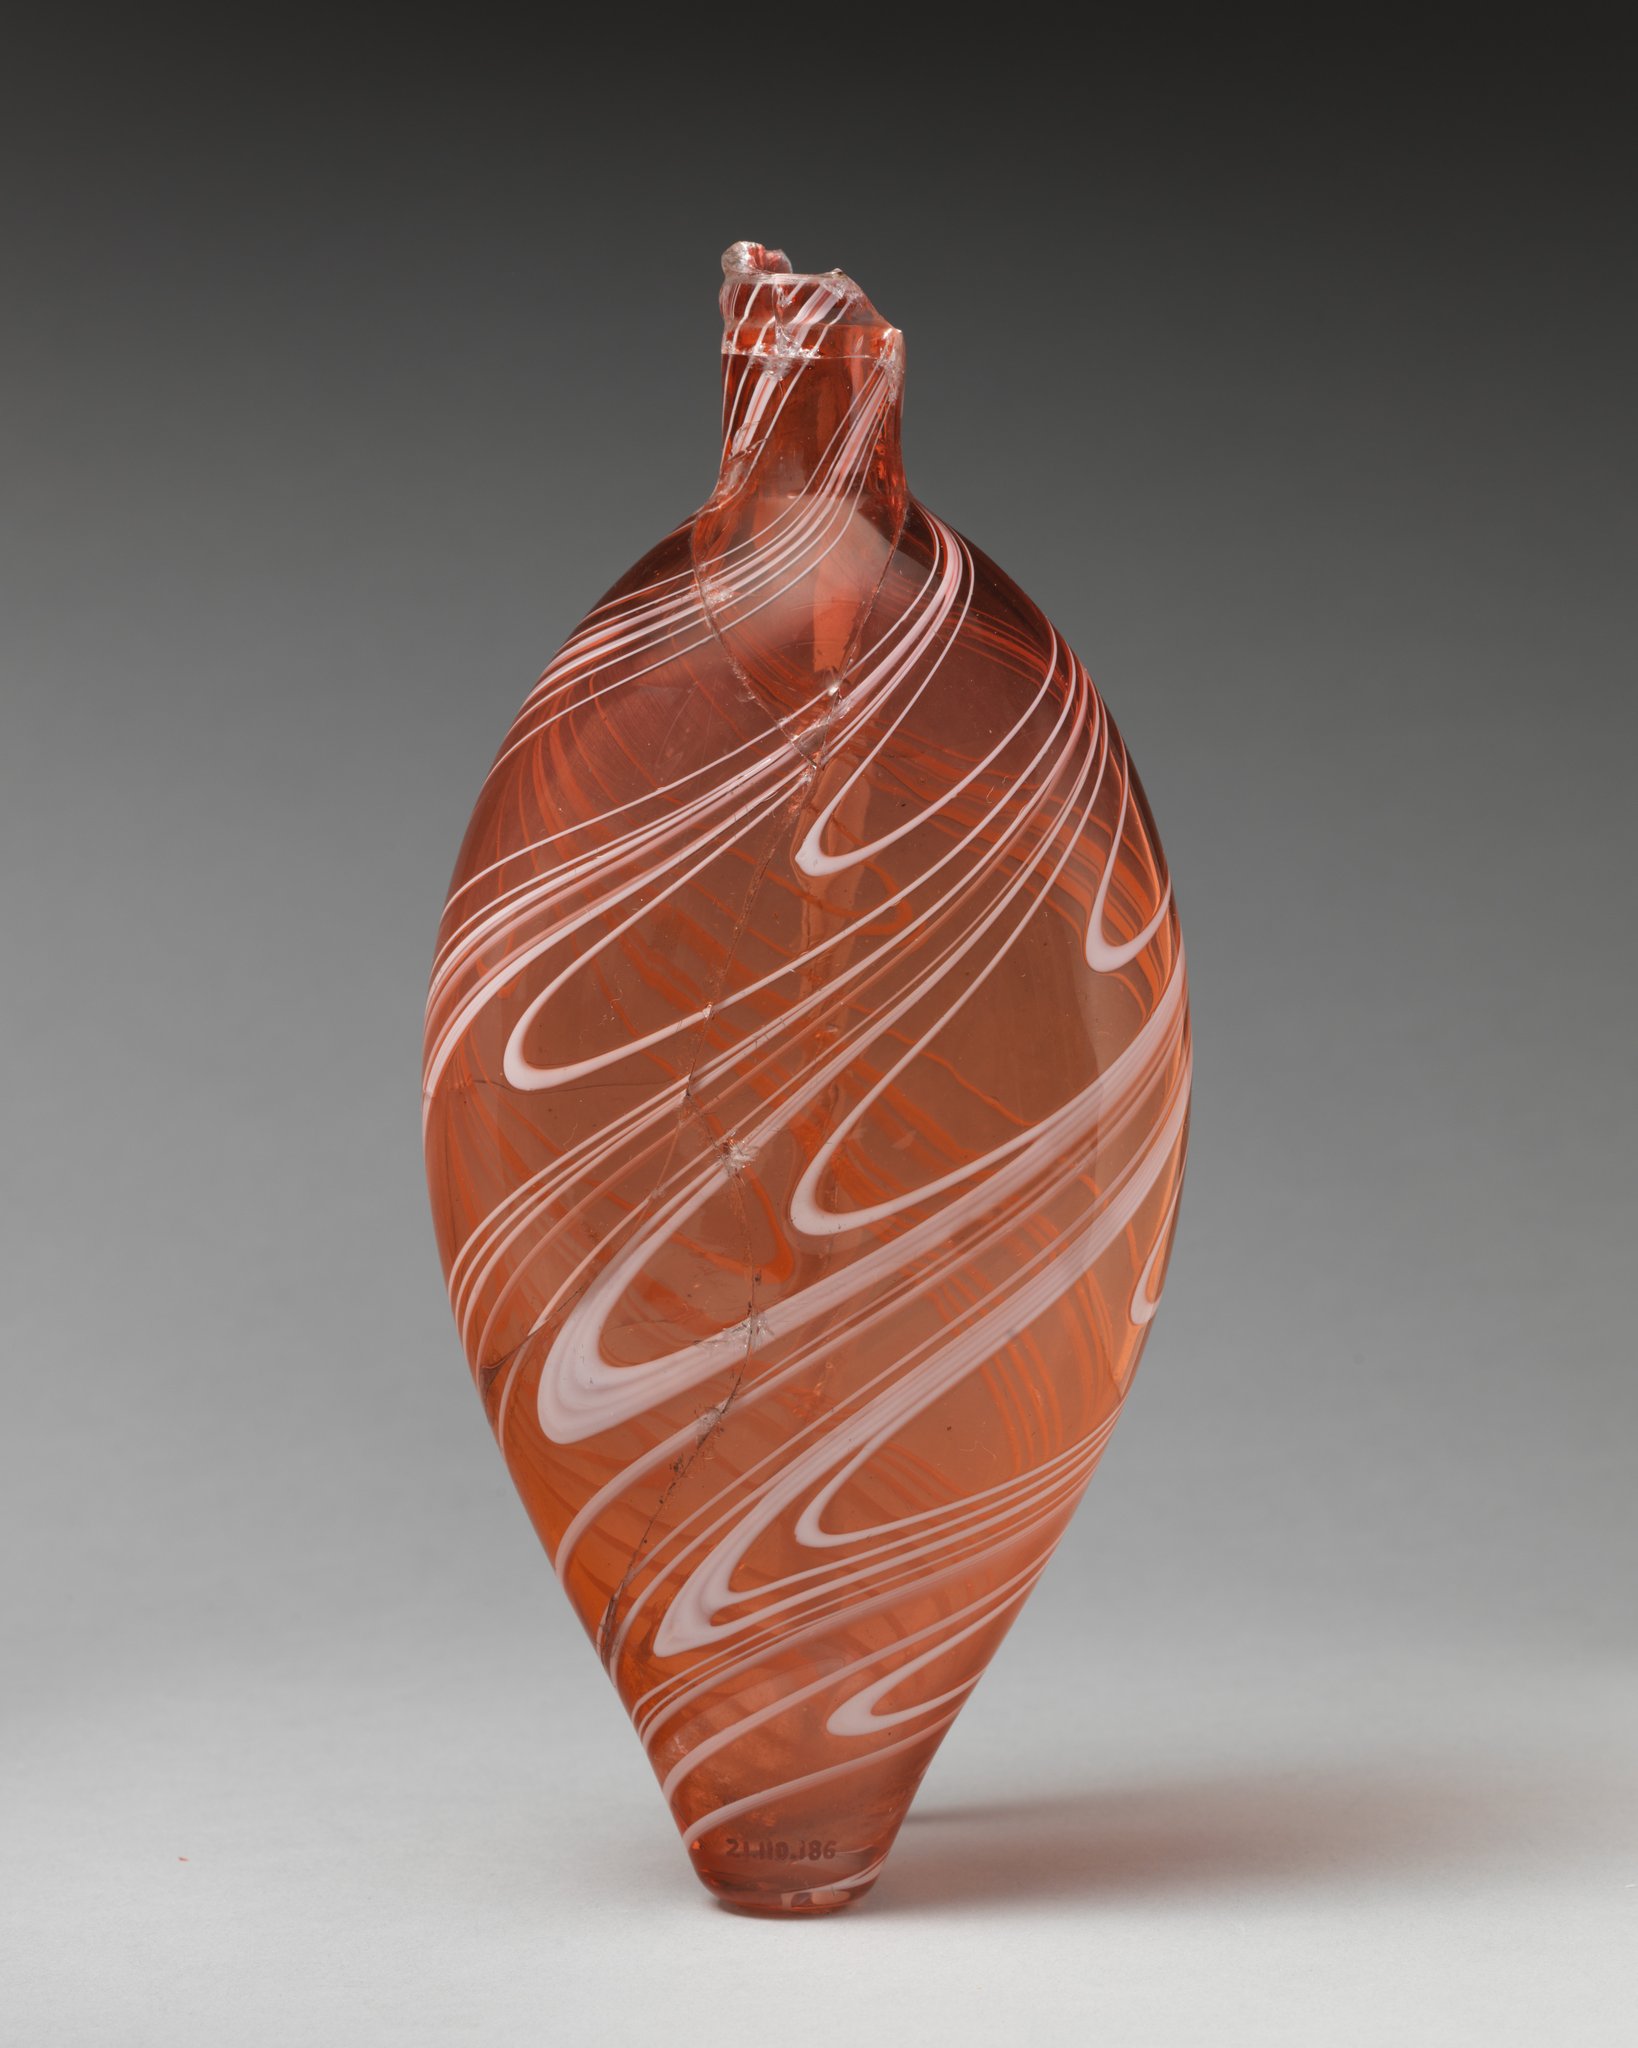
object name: flask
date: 1767-1833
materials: glass